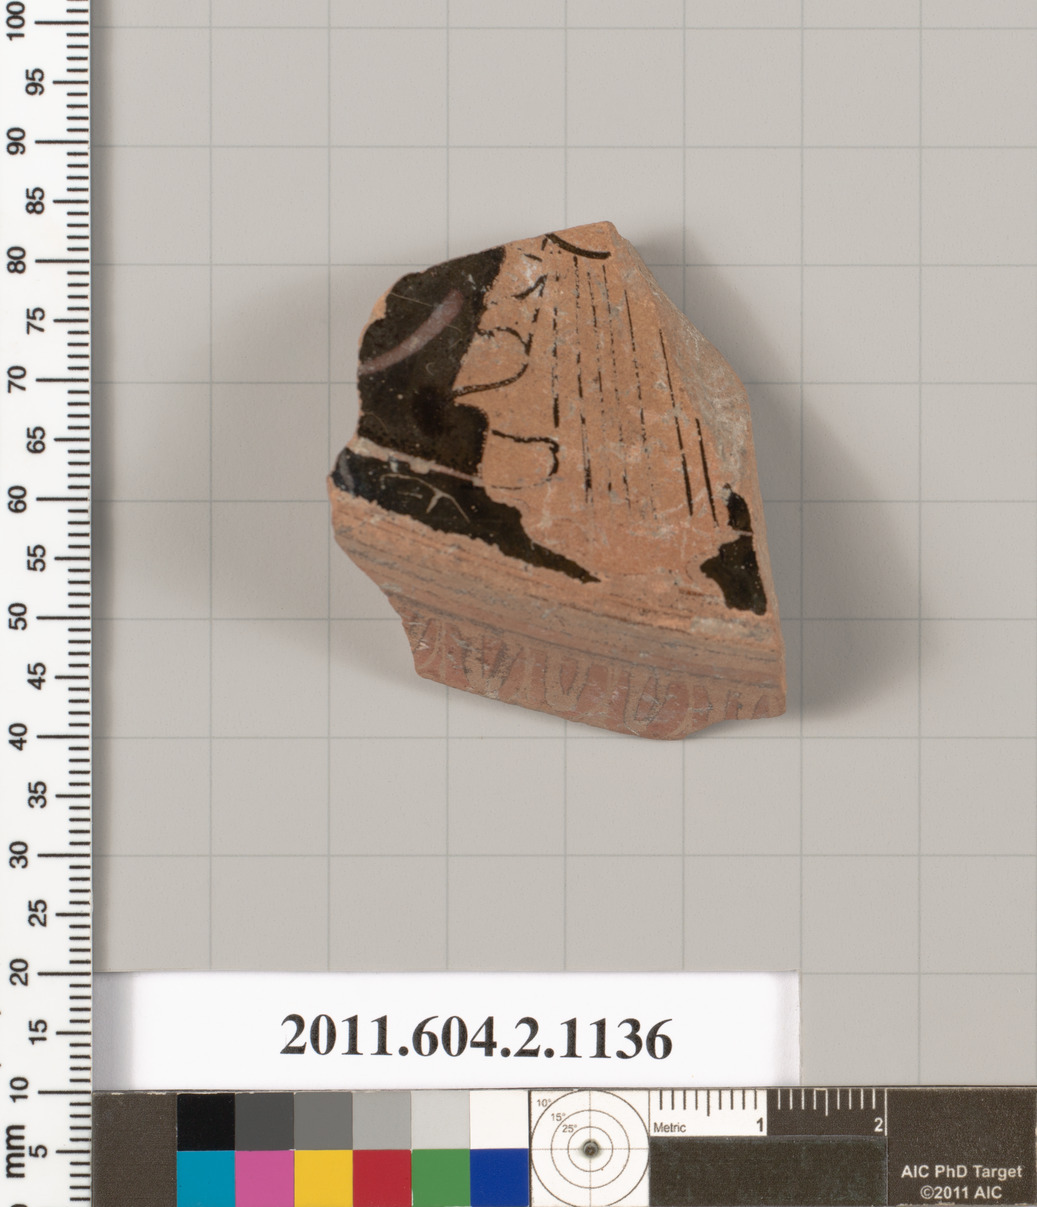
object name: lekanis fragment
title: Terracotta fragment of a lekanis lid (covered dish)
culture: greek, attic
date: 375-351 BCE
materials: terracotta